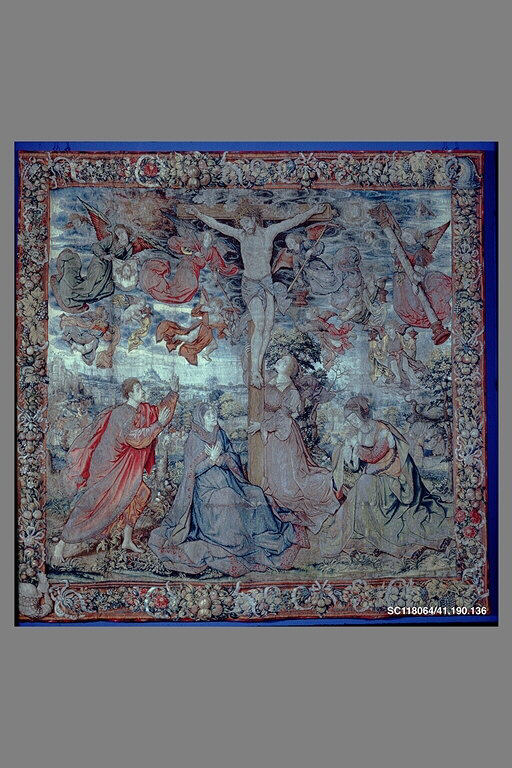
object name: tapestry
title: The Crucifixion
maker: bernard van orley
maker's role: designer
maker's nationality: netherlandish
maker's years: 1492-1542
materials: silk, silver gilt, thread, wool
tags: angels,christ,crucifixion